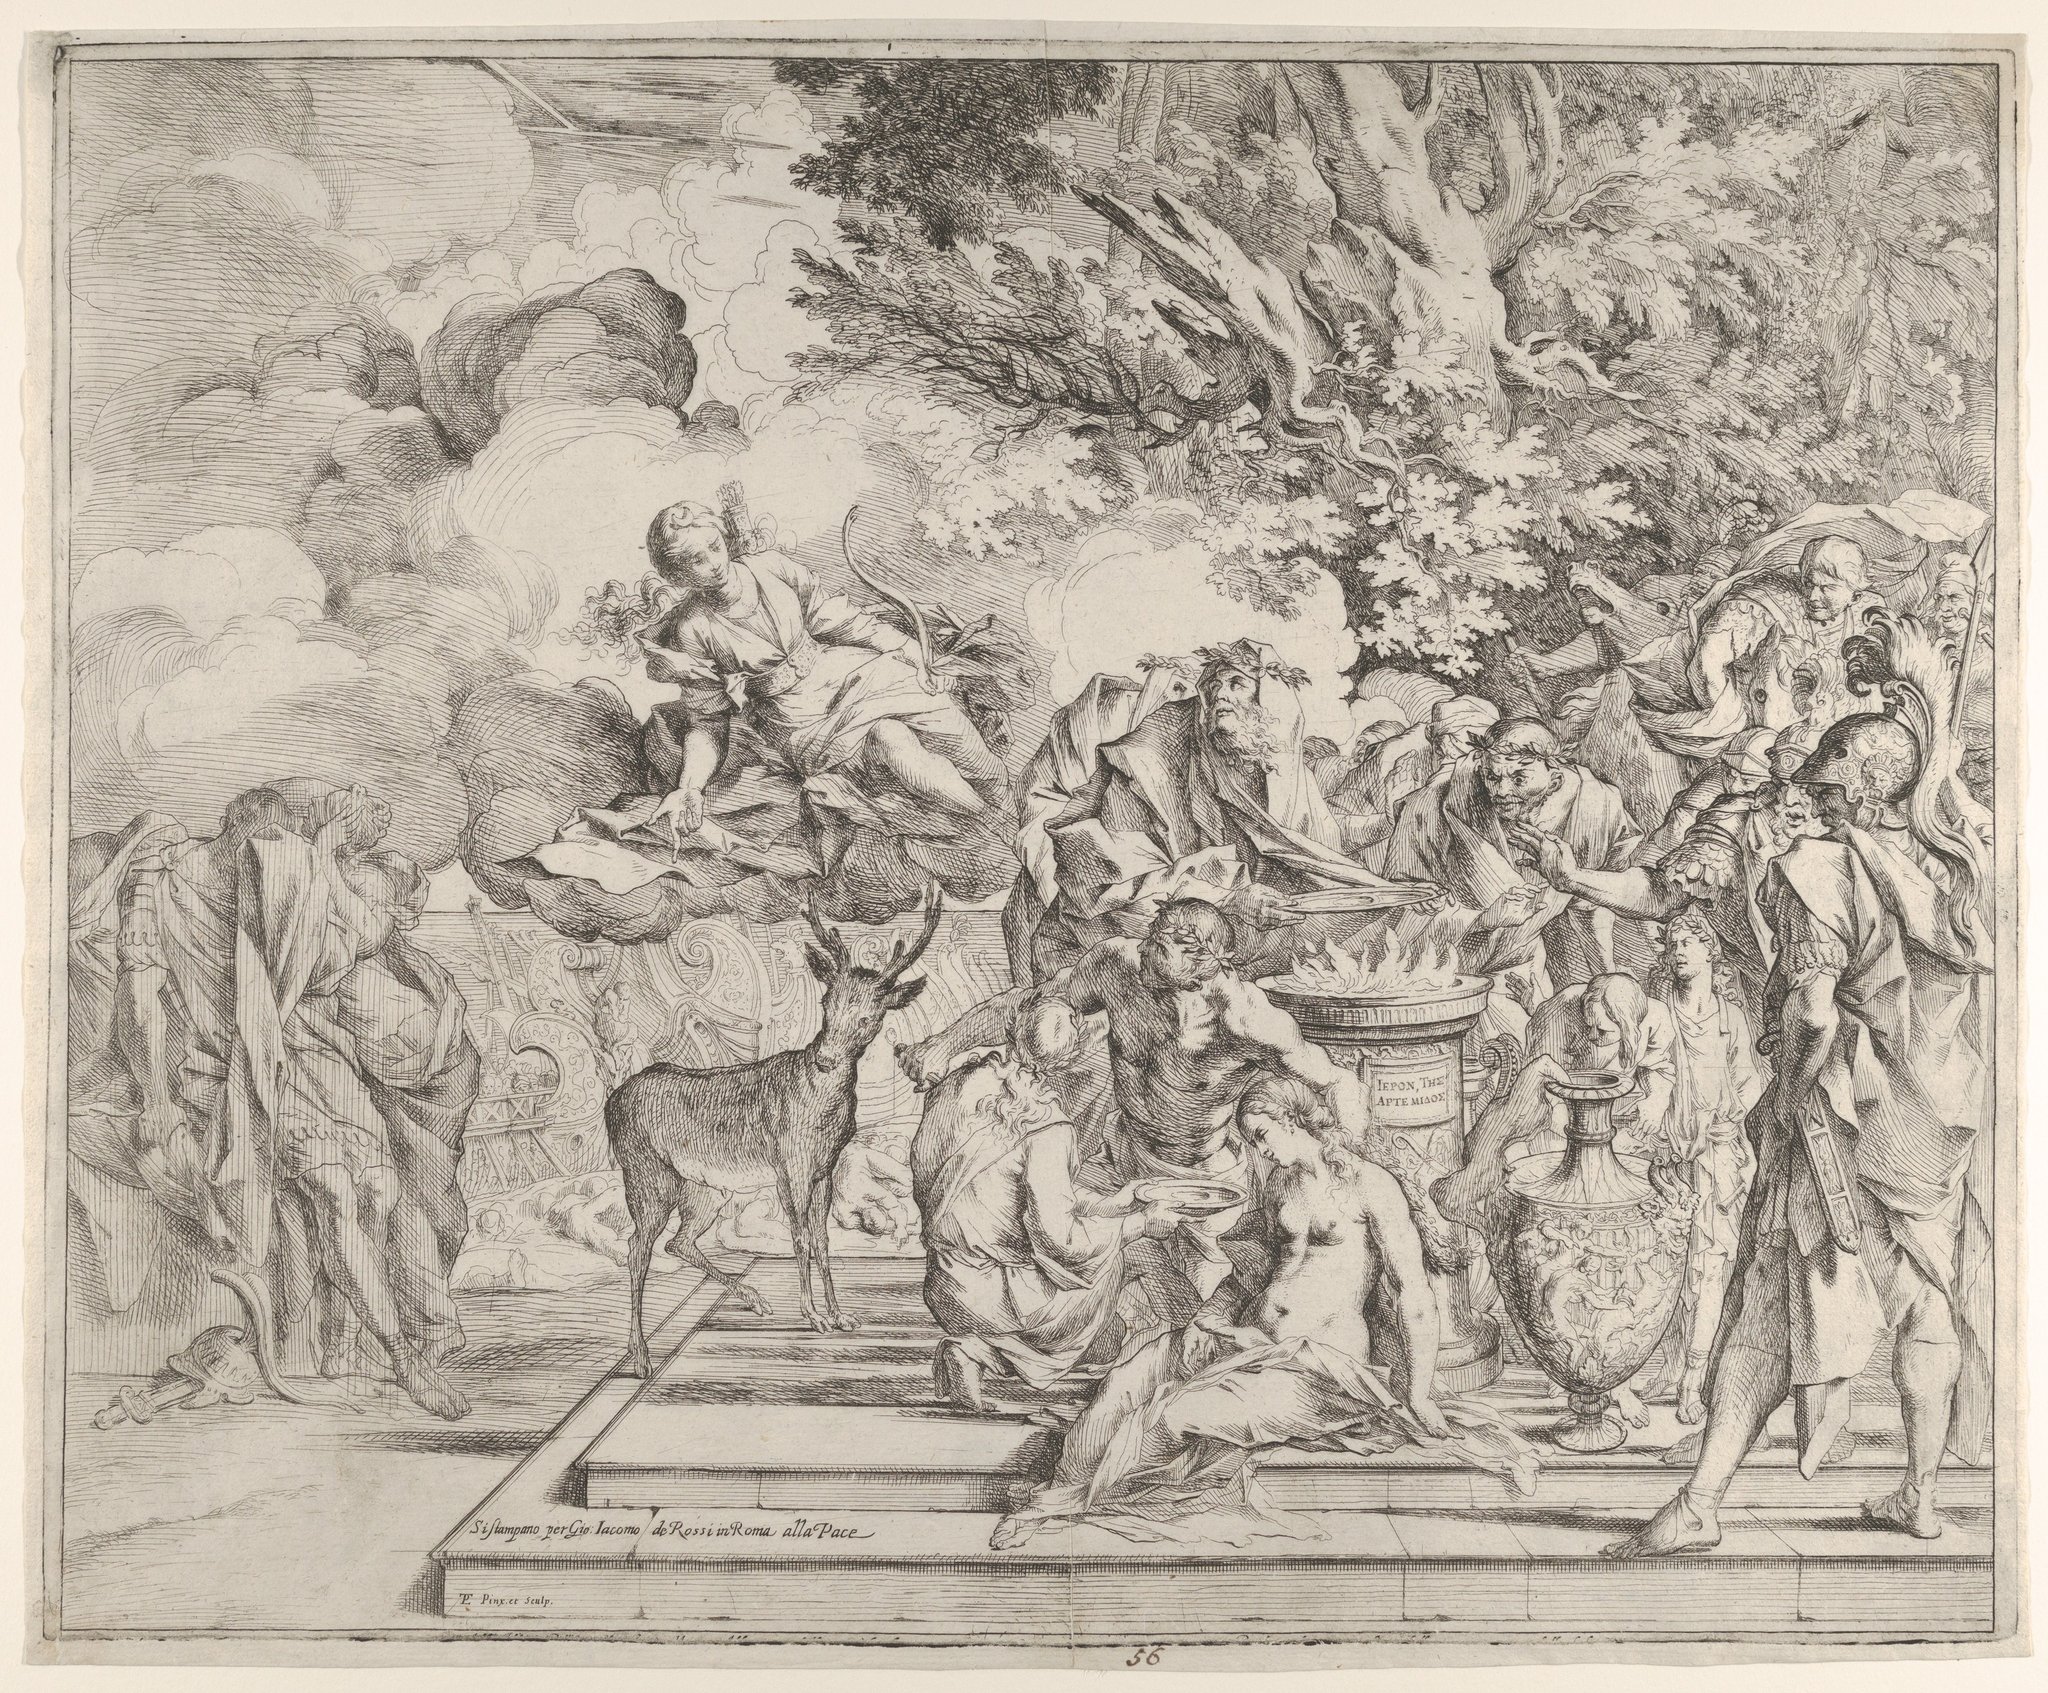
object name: print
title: The Sacrifice of Iphigenia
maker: pietro testa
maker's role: artist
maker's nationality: italian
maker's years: 1612-1650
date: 1640-1642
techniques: drypoint, etching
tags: trojan war,men,women,iphigenia,deer